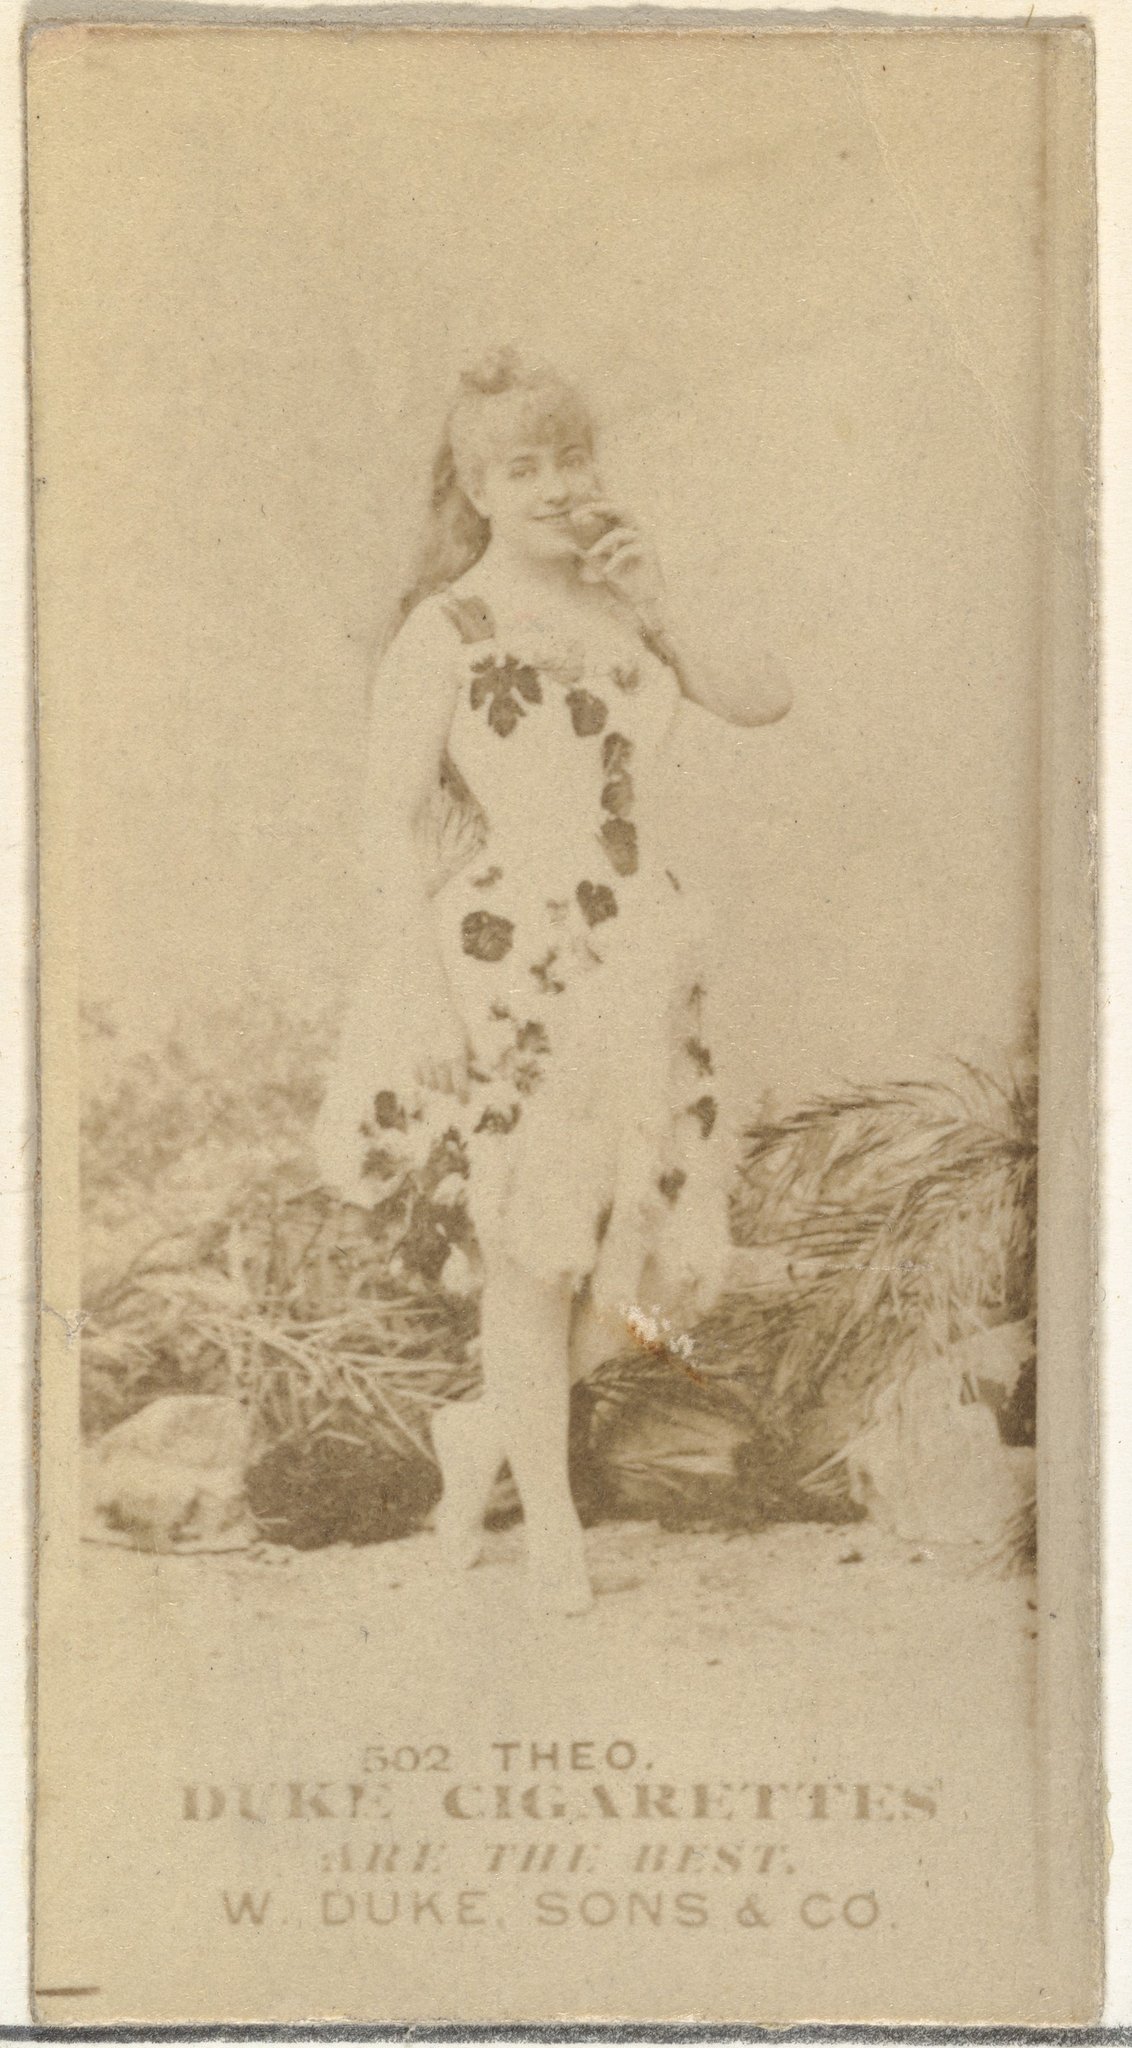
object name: photograph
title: Card Number 502, Theo, from the Actors and Actresses series (N145-7) issued by Duke Sons & Co. to promote Duke Cigarettes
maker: w. duke, sons & co.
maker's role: publisher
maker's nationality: american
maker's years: 1870-1920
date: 1880-1889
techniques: albumen silver print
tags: portraits,women,actresses